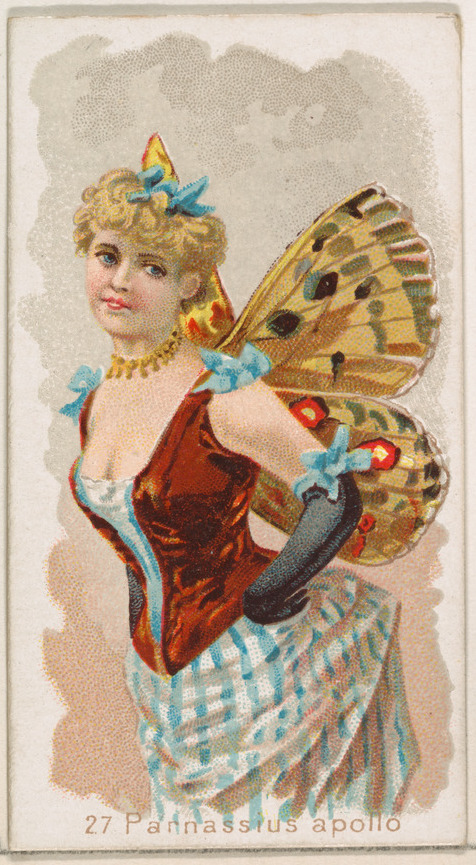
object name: print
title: Card 27, Parnassius Apollo, from the Butterflies series (N183) issued by Wm. S. Kimball & Co.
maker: william s. kimball & company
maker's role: publisher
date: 1888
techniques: color lithograph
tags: women